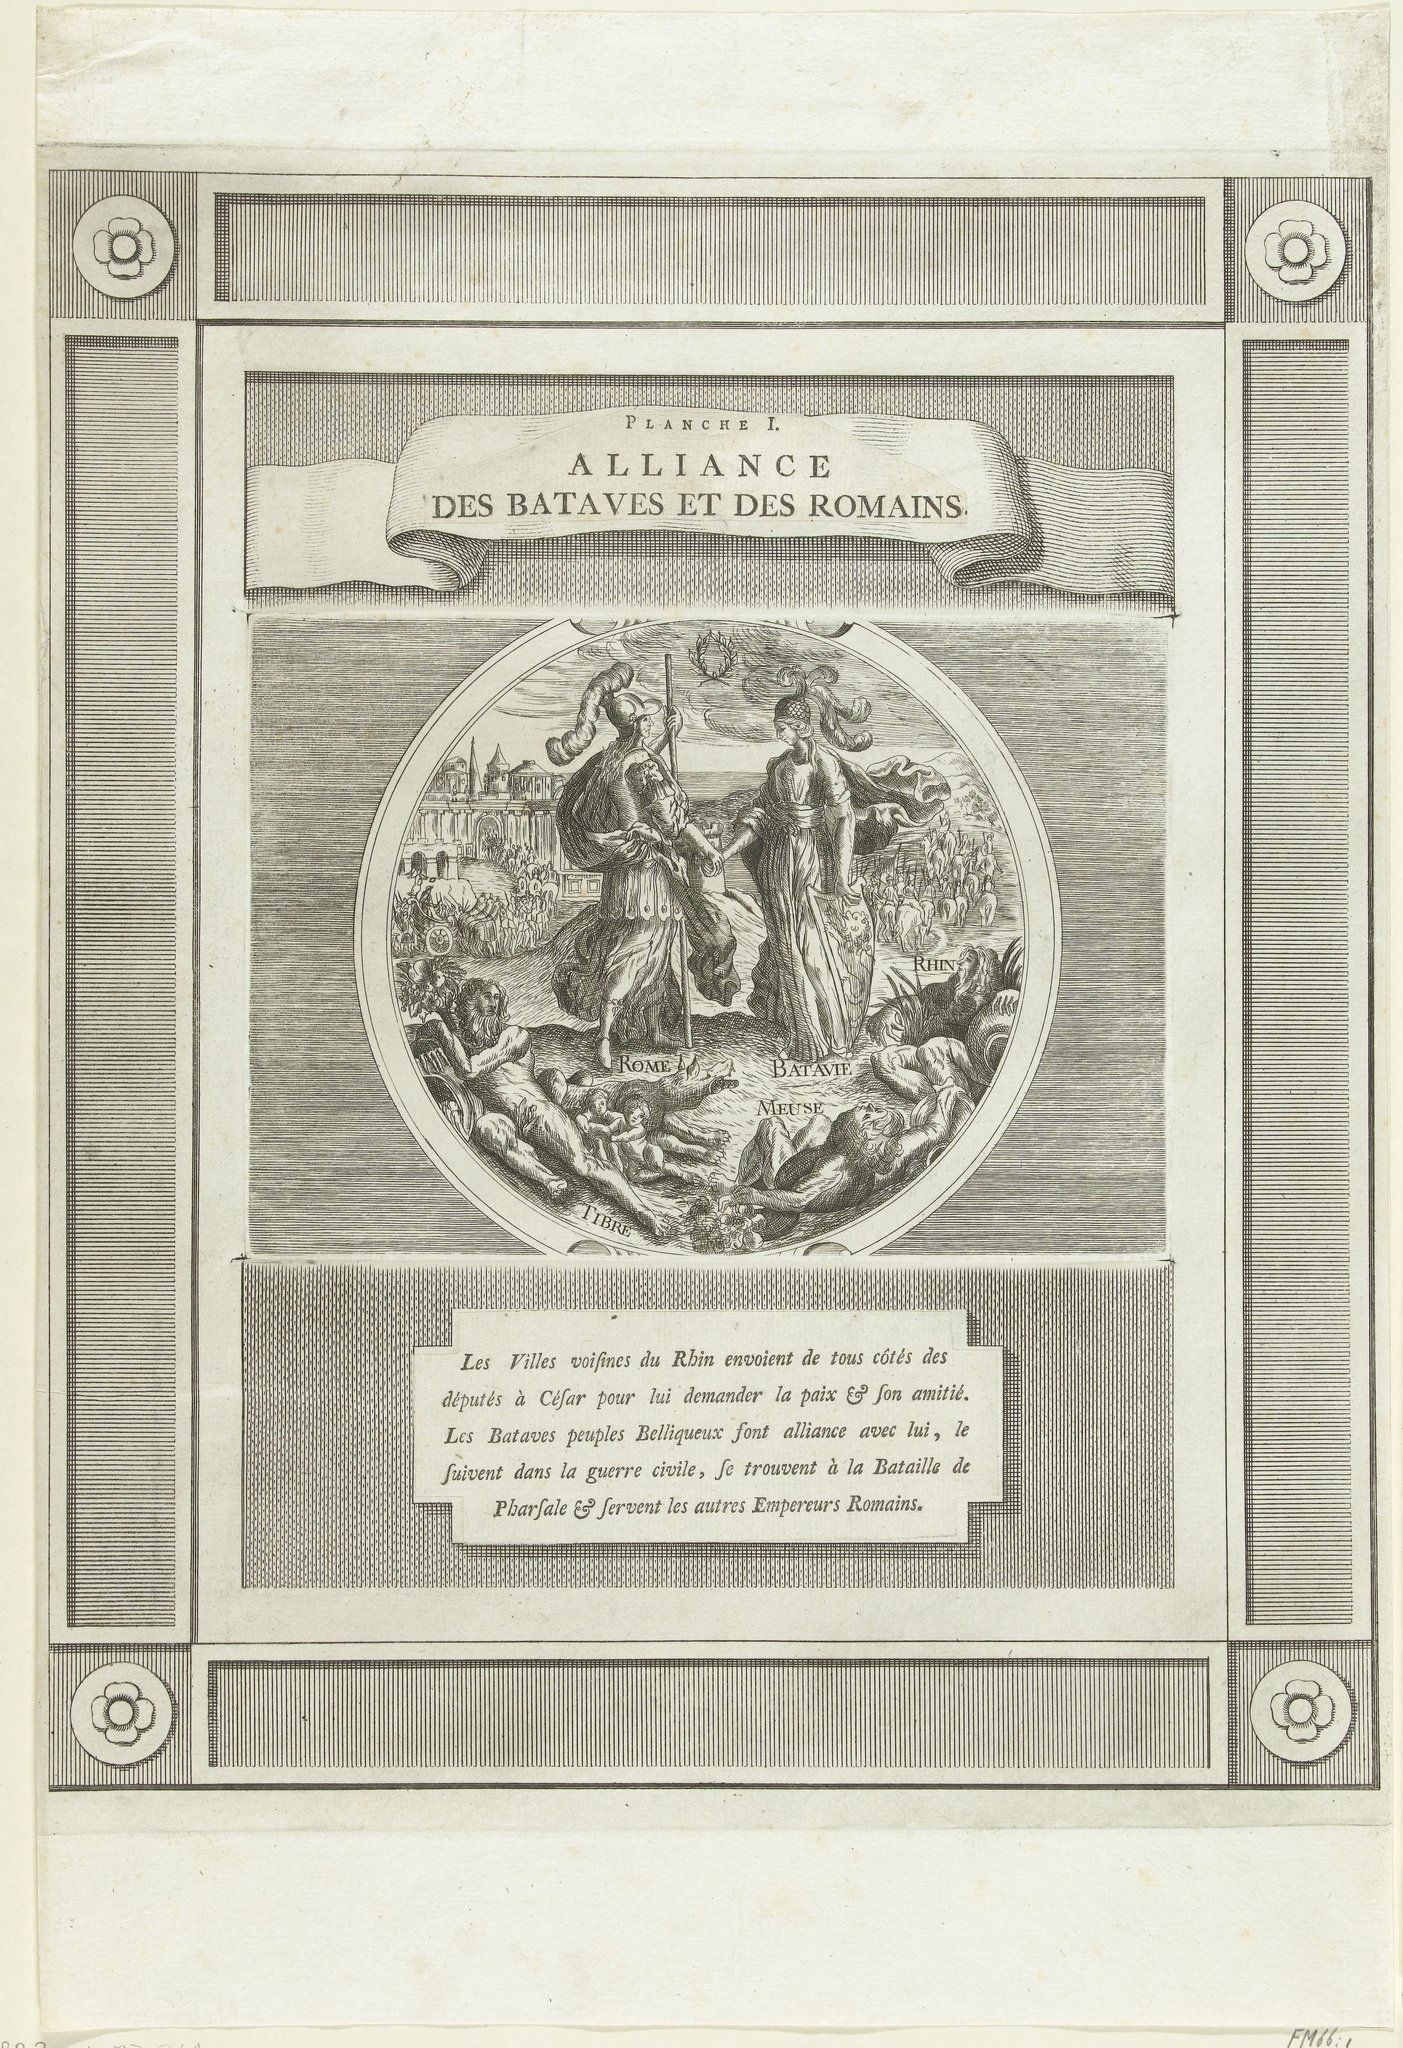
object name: titelprent, frontispice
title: Kopieën naar Tempesta's Bataafse Opstand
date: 1768-1770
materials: paper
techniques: engraving, etching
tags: personifications of countries, nations, states, districts, etc., extinct, 'historical' peoples (with name), netherlands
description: Ronde allegorische voorstelling waarin personificaties Roma en Batavia op het slagveld elkaar de hand schudden. Op de voorgrond de riviergoden van de Tiber, Maas, en Rijn. Eerste prent in een serie over de Bataafse Opstand, gekopieerd naar de reeks Batavorum cum Romanis bellum van Antonio Tempesta (Otto Vaenius, Antwerpen 1612). Illustratie voor: Marquis de St. Simon, Histoire de la guerre des Bataves et des Romains, d'après César; Corneille Tacite, Aux dépens de Marc-Michel Rey, Amsterdam 1770. Voorstellingen gedrukt in een grote ornamentele omlijsting waarin bovenaan een uitgeknipte titel en onderaan een onderschrift in het Frans is geplakt.